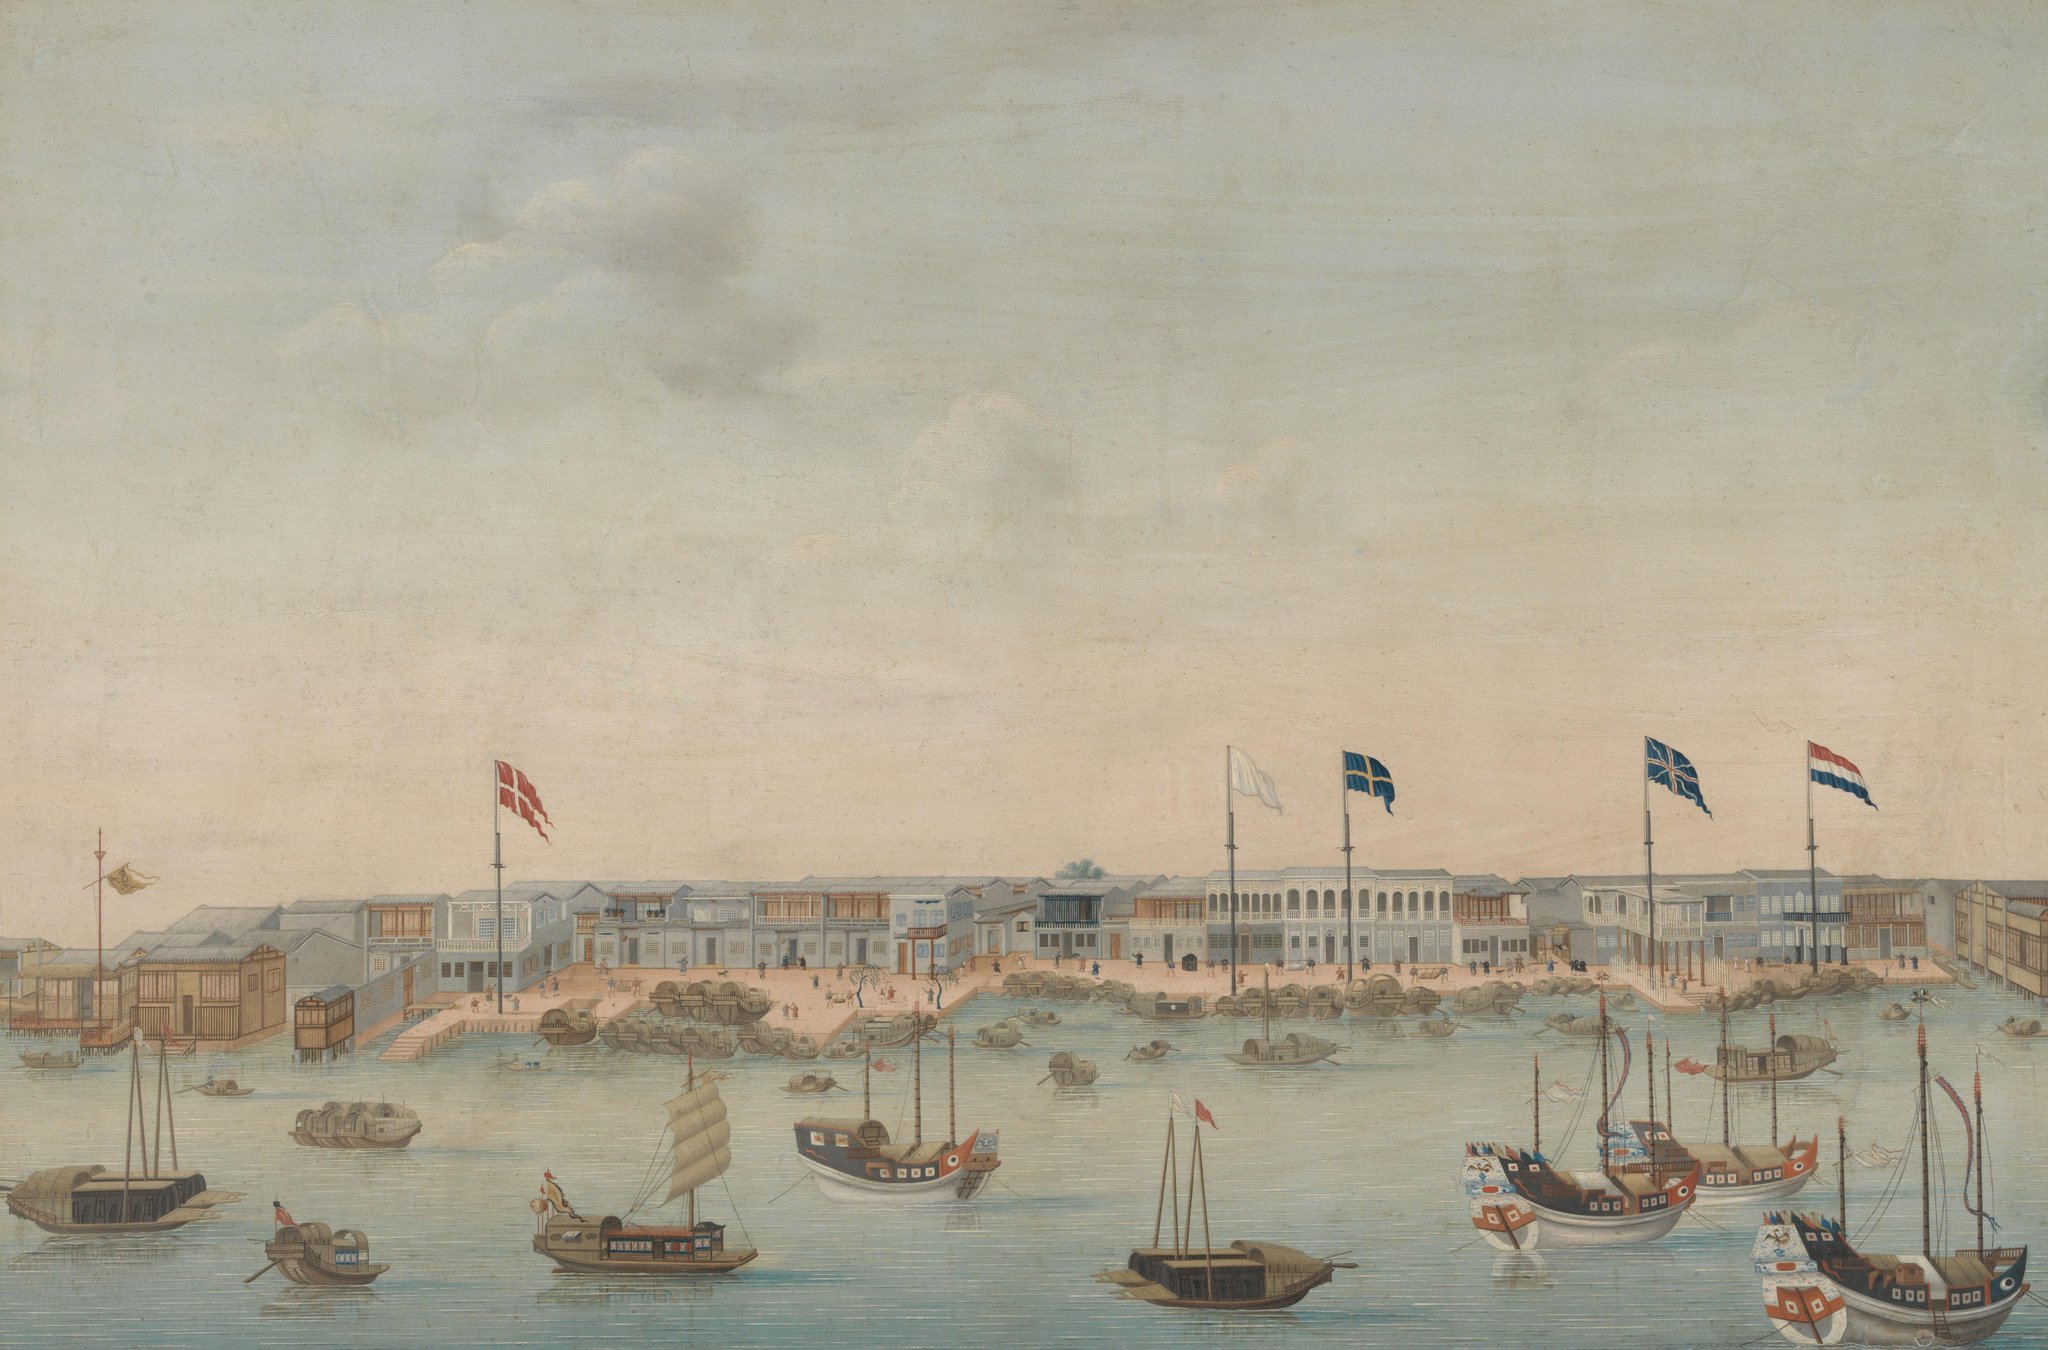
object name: painting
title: Three Views of the Pearl River: Canton, Macao, Whampoa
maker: Anonymous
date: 1773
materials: canvas, oil, paint, paper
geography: china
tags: ship in the roads, roadstead, coast, prospect of city, town panorama, silhouette of city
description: Various European trade organizations had branches in the port of Canton. Because there was so much construction, the paintings can be easily dated. This is the situation in 1773. The ships are moored in the estuary of the Pearl River (Whampoa); the merchants’ offices were located upriver. During the off-season the European traders stayed in Macao, which was also in the mouth of the Pearl River.